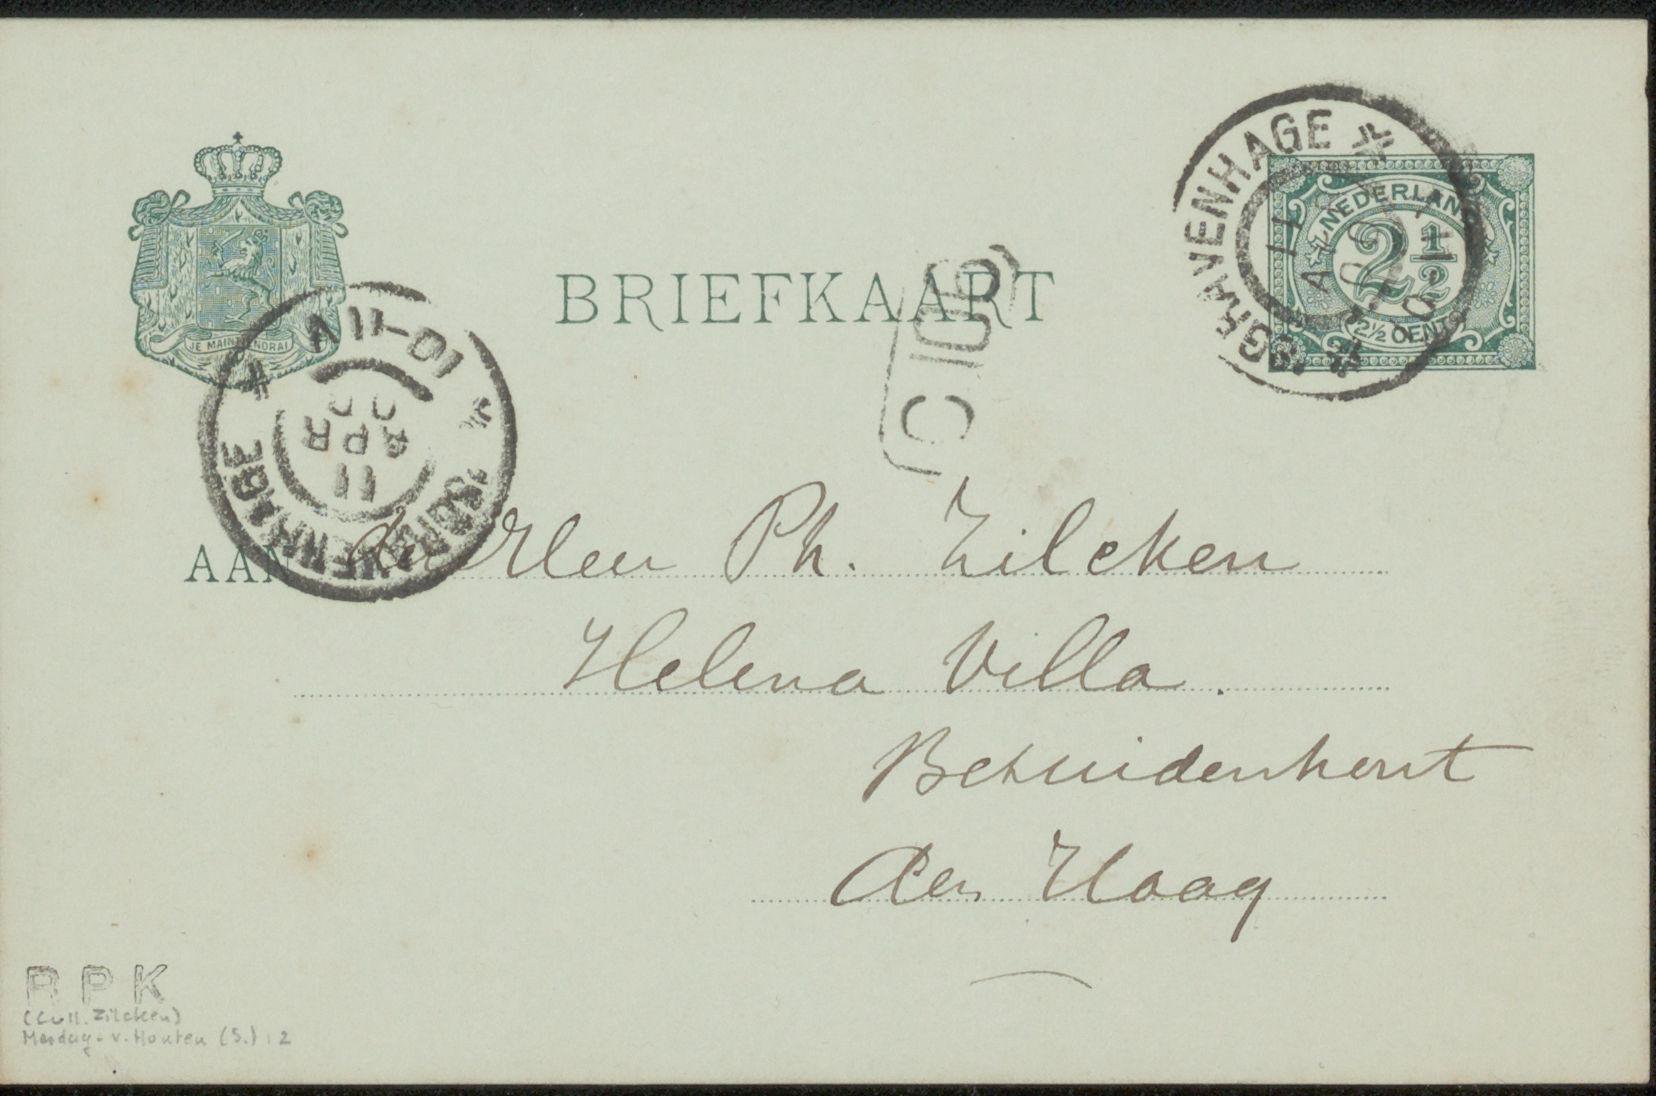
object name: postcard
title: Briefkaart aan Philip Zilcken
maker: sientje mesdag-van houten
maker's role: draughtsman, painter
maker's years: 1834-1909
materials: cardboard, ink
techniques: pen, writing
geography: the hague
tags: painter, draughtsman, philip zilcken, printed matter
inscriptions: collector's mark: ‘RPK’